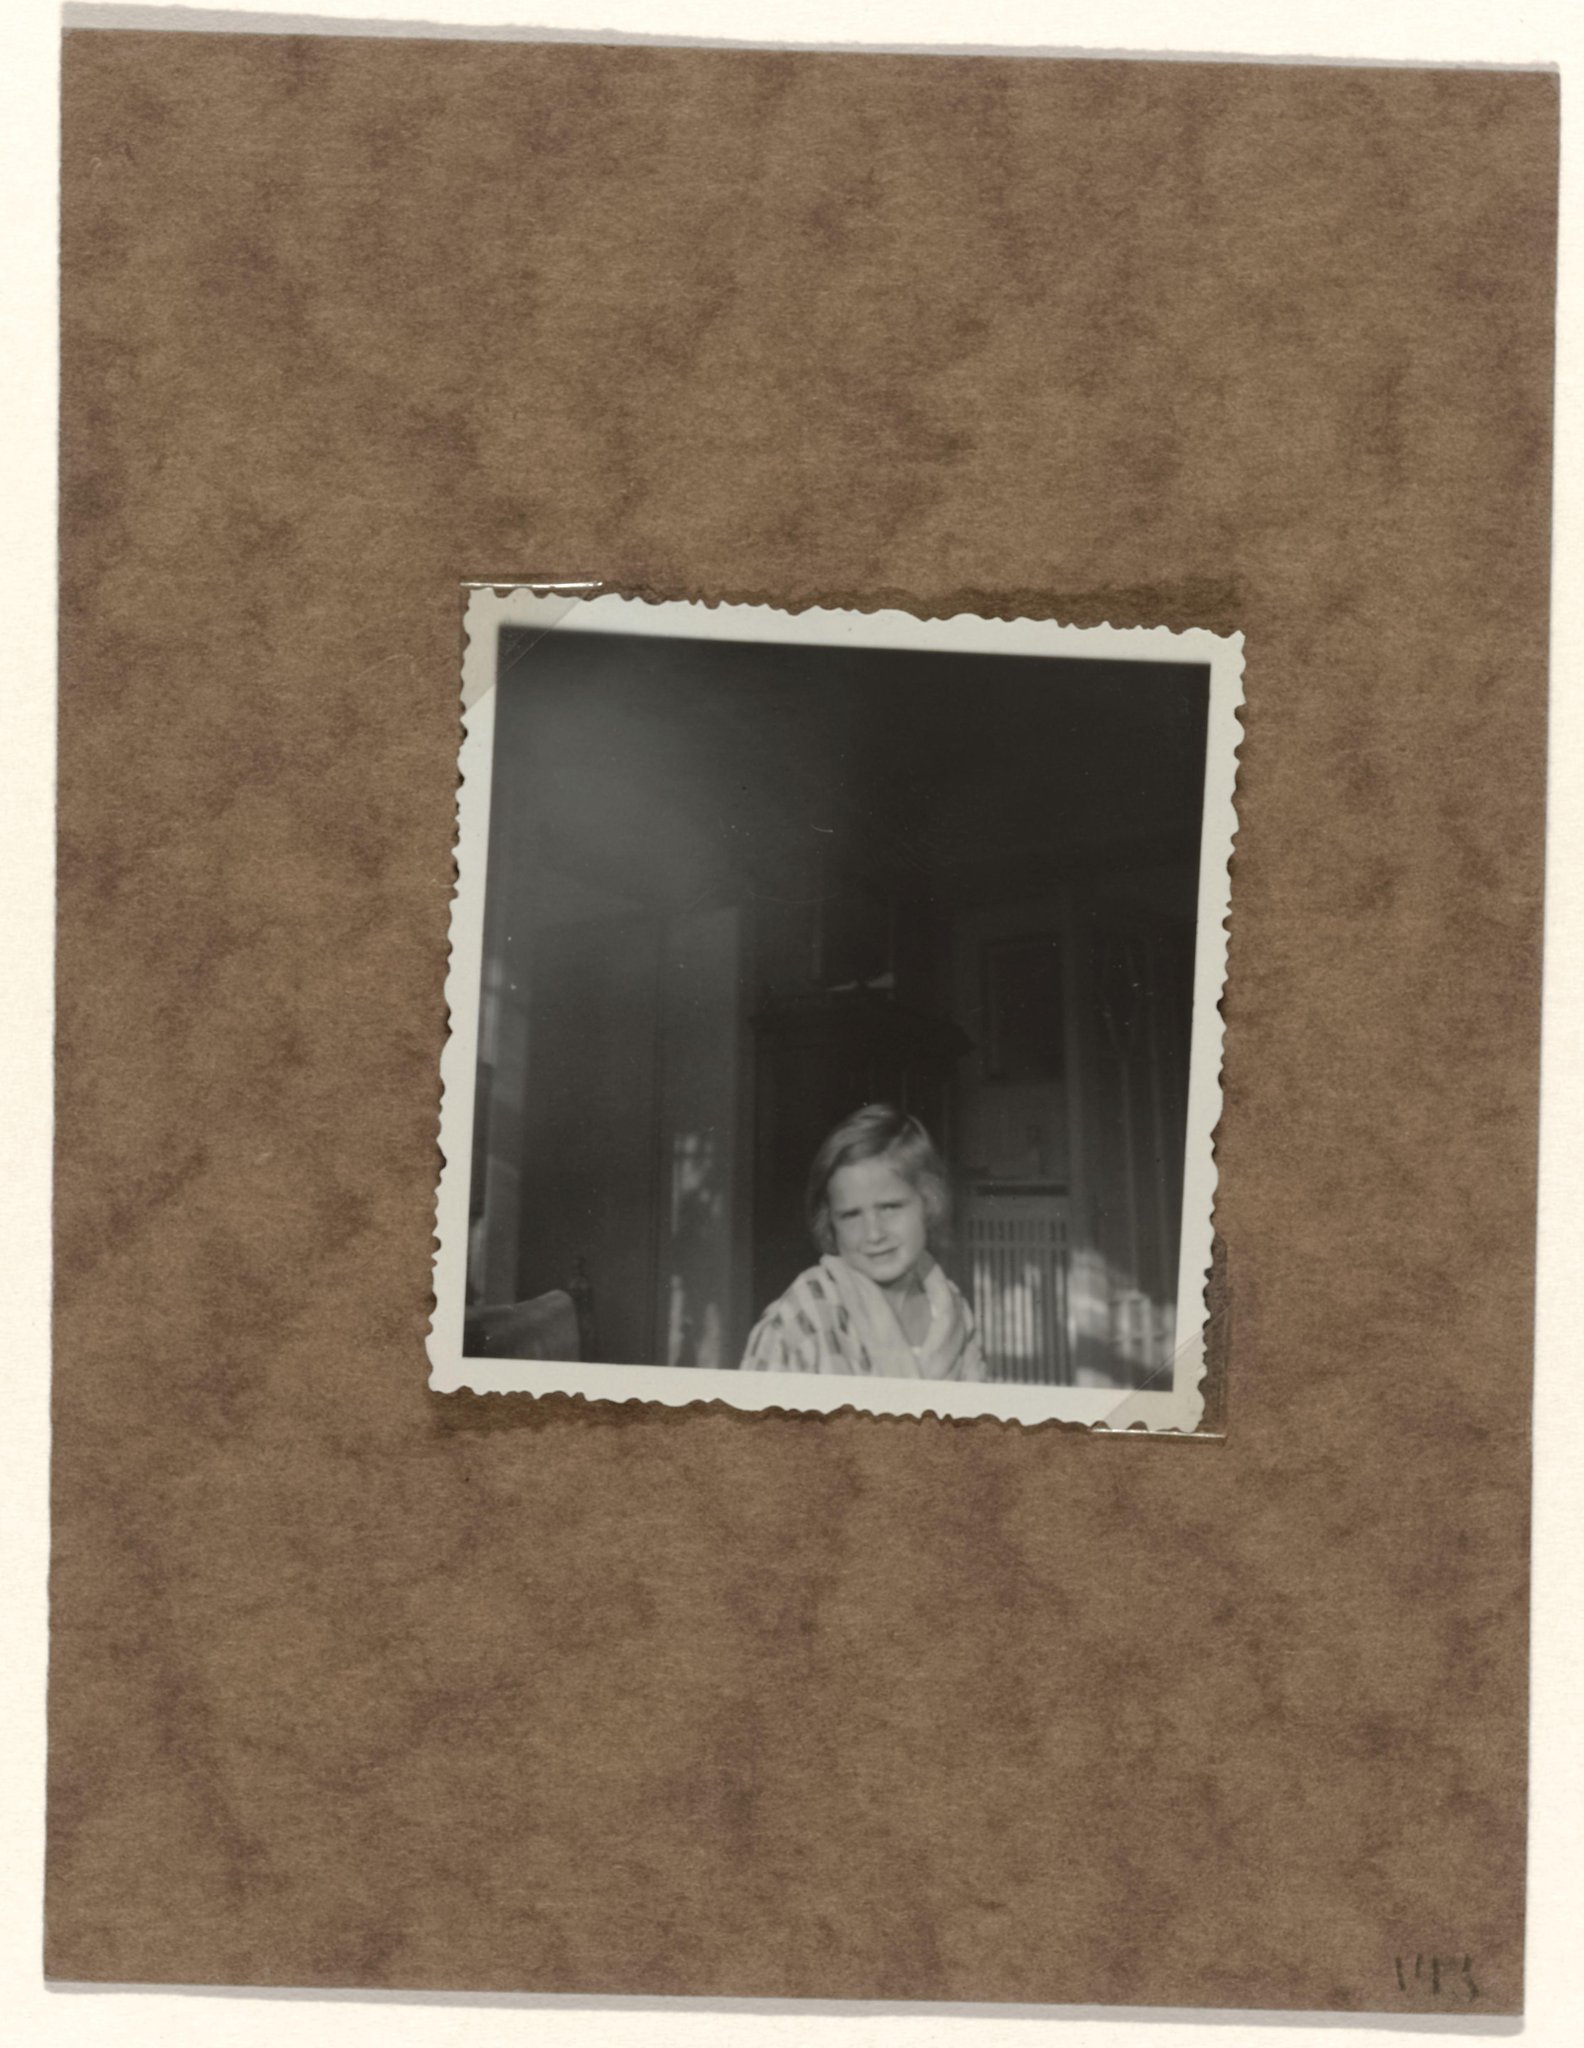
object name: photograph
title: Isabel Wachenheimer in gestreepte ochtendjas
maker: Anonymous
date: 1932-1937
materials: photographic support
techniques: gelatin silver print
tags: leiden, isabel wachenheimer-elon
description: Isabel Wachenheimer in een gestreepte ochtendjas.